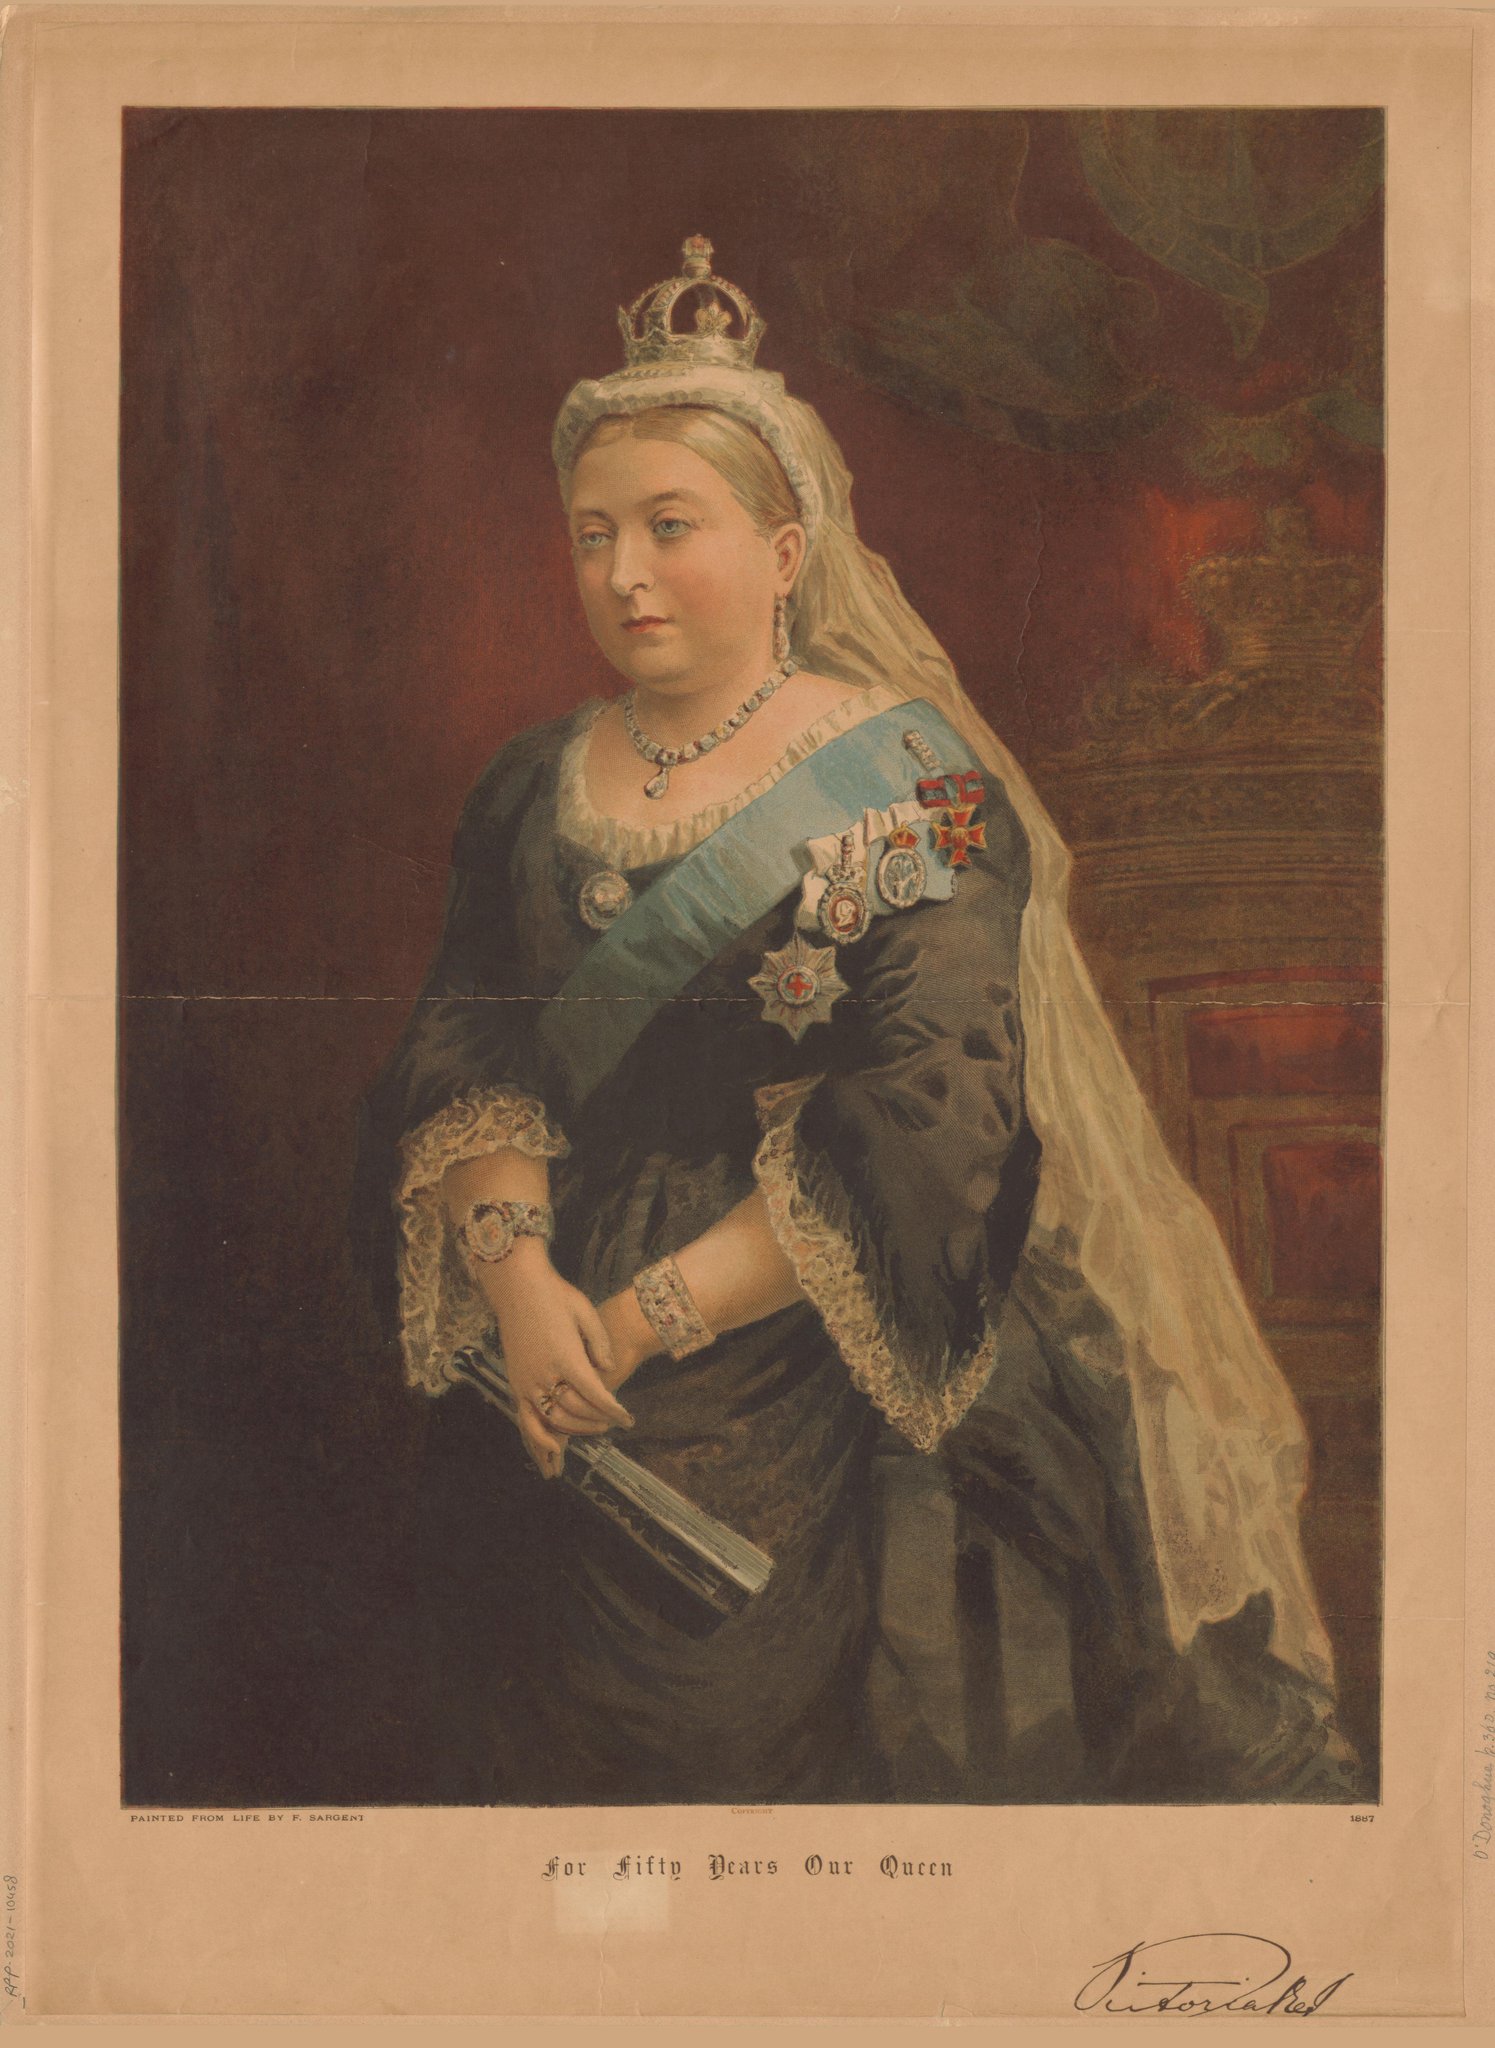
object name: print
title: Portret van Victoria, koningin van Engeland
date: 1887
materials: paper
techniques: lithograph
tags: victoria (koningin van het verenigd koninkrijk en keizerin van india), historical persons, queen, fan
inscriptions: : ‘Copyright.’, inscription: ‘supplement to the graphic jubileu number/ Juni 20 1887’